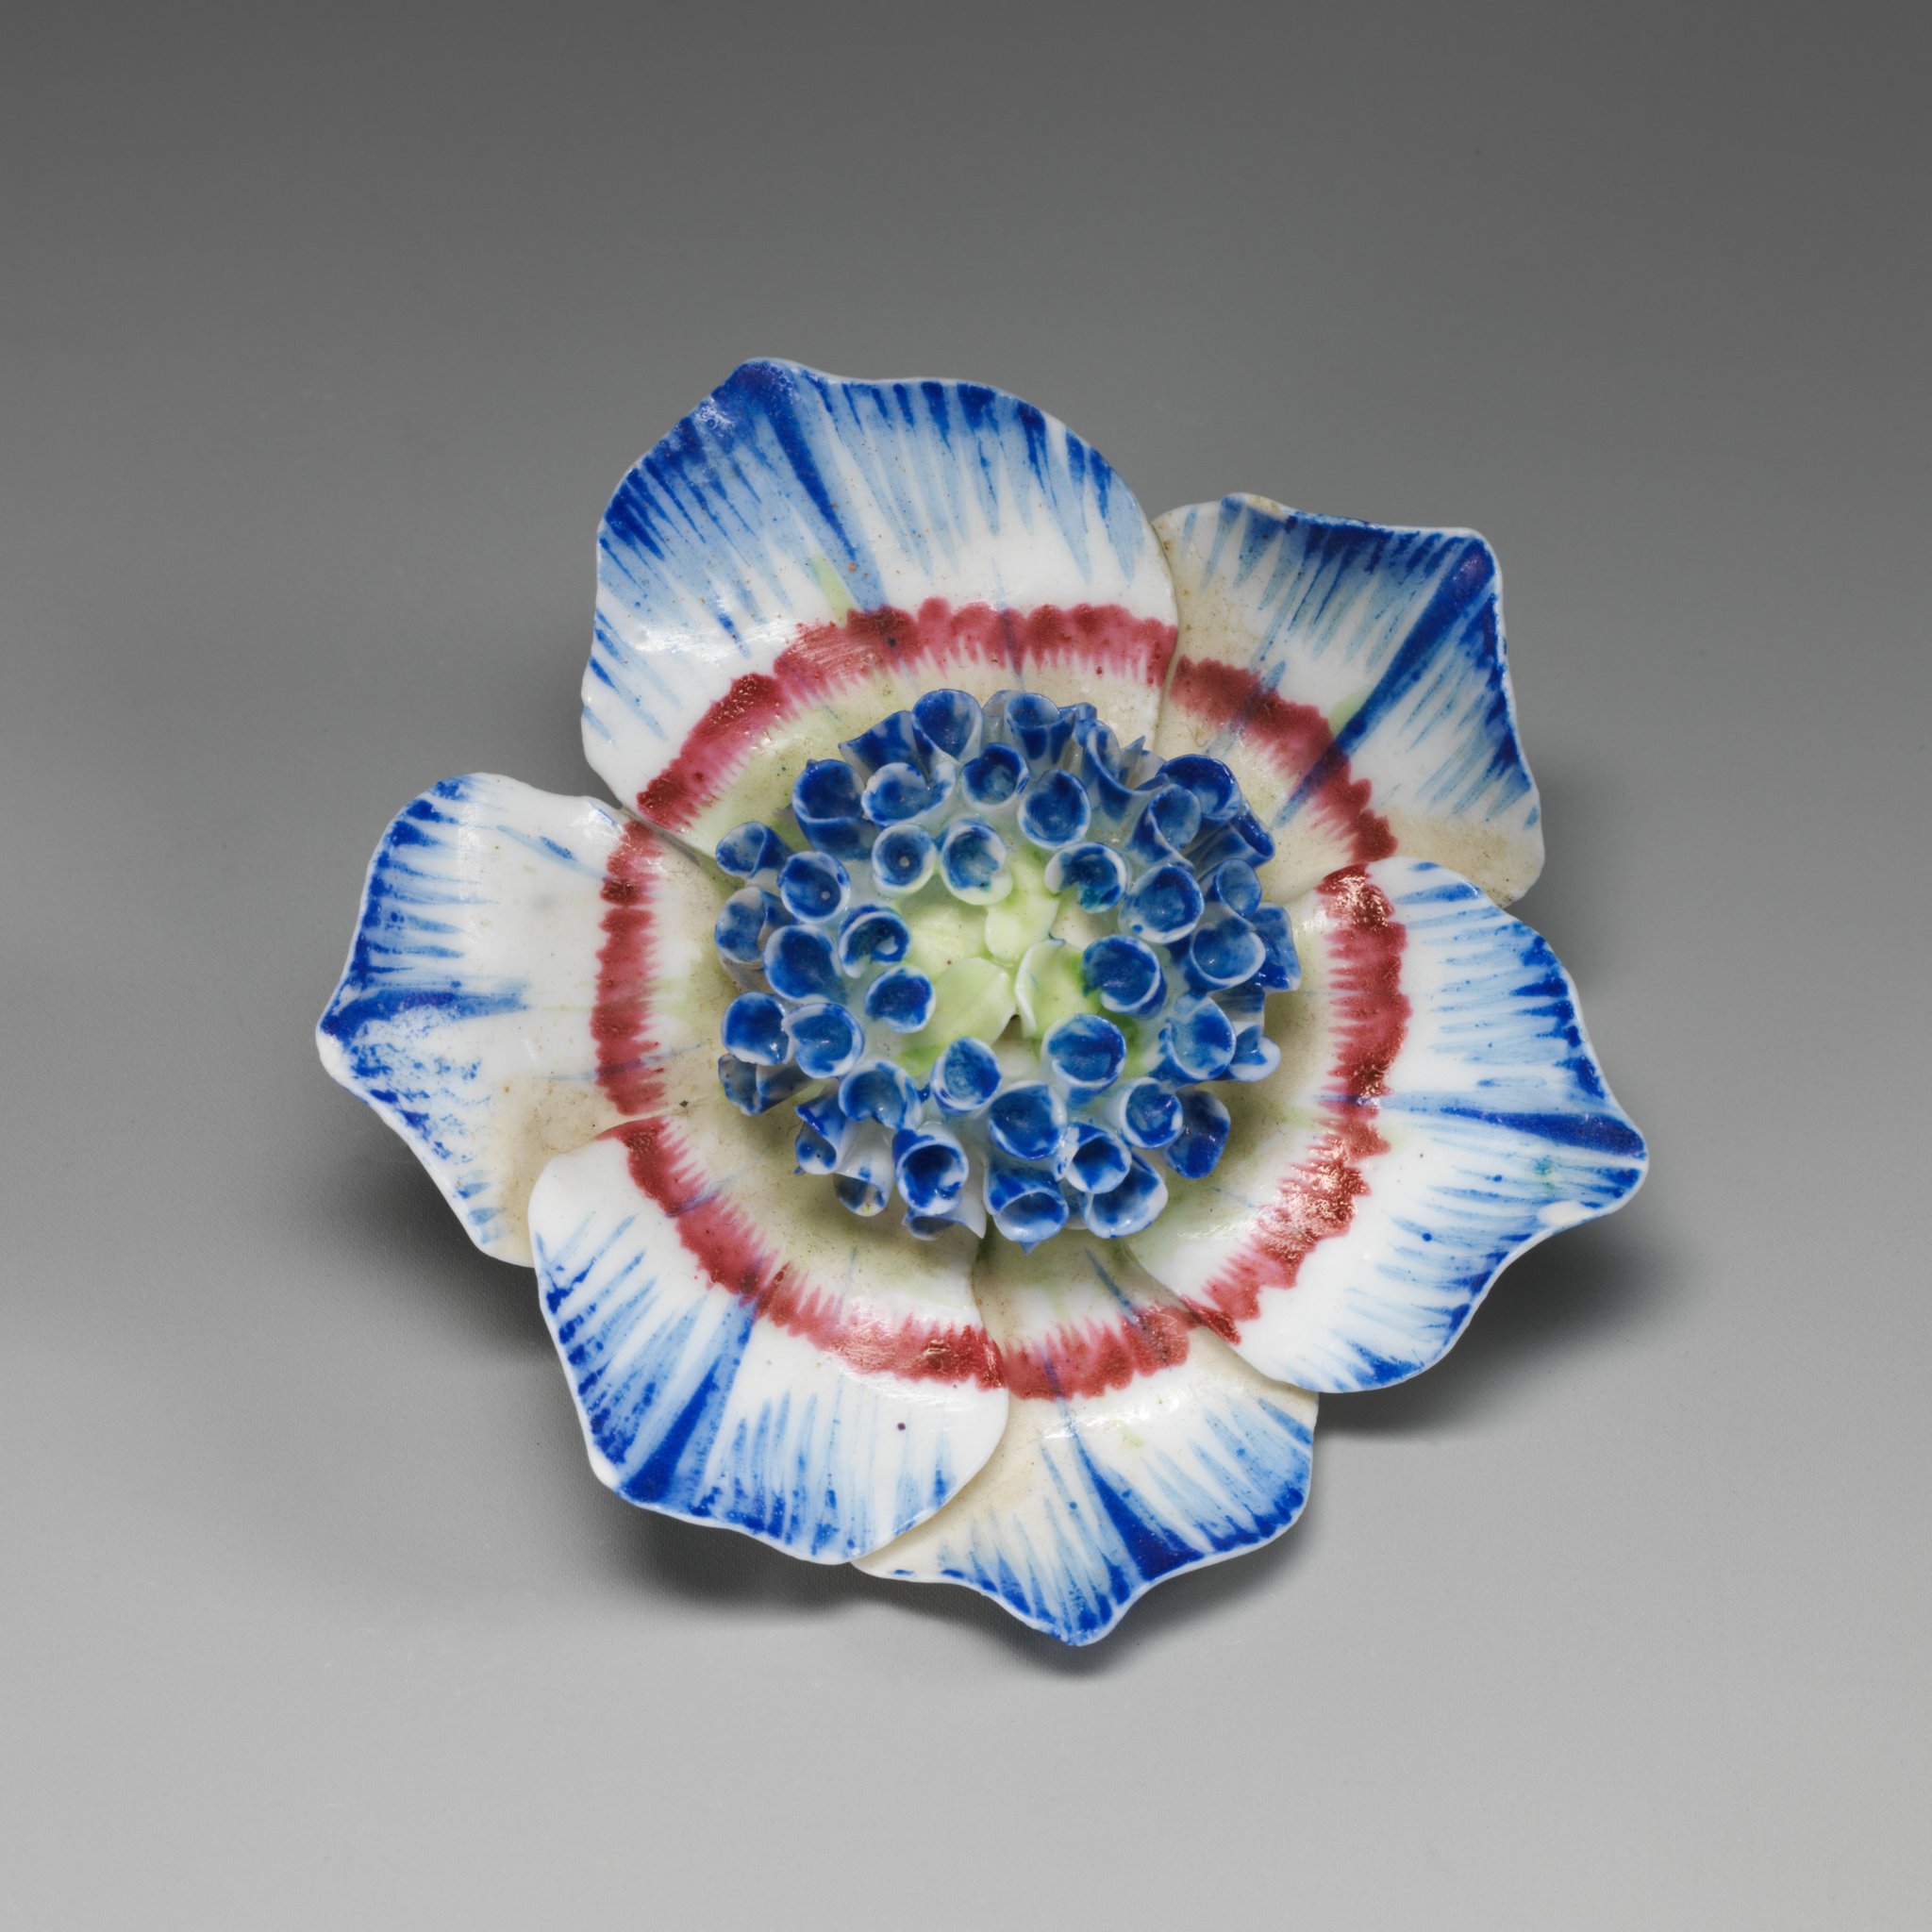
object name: porcelain flower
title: Porcelain flower (one of a set of nine)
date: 1734-1766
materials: soft paste porcelain